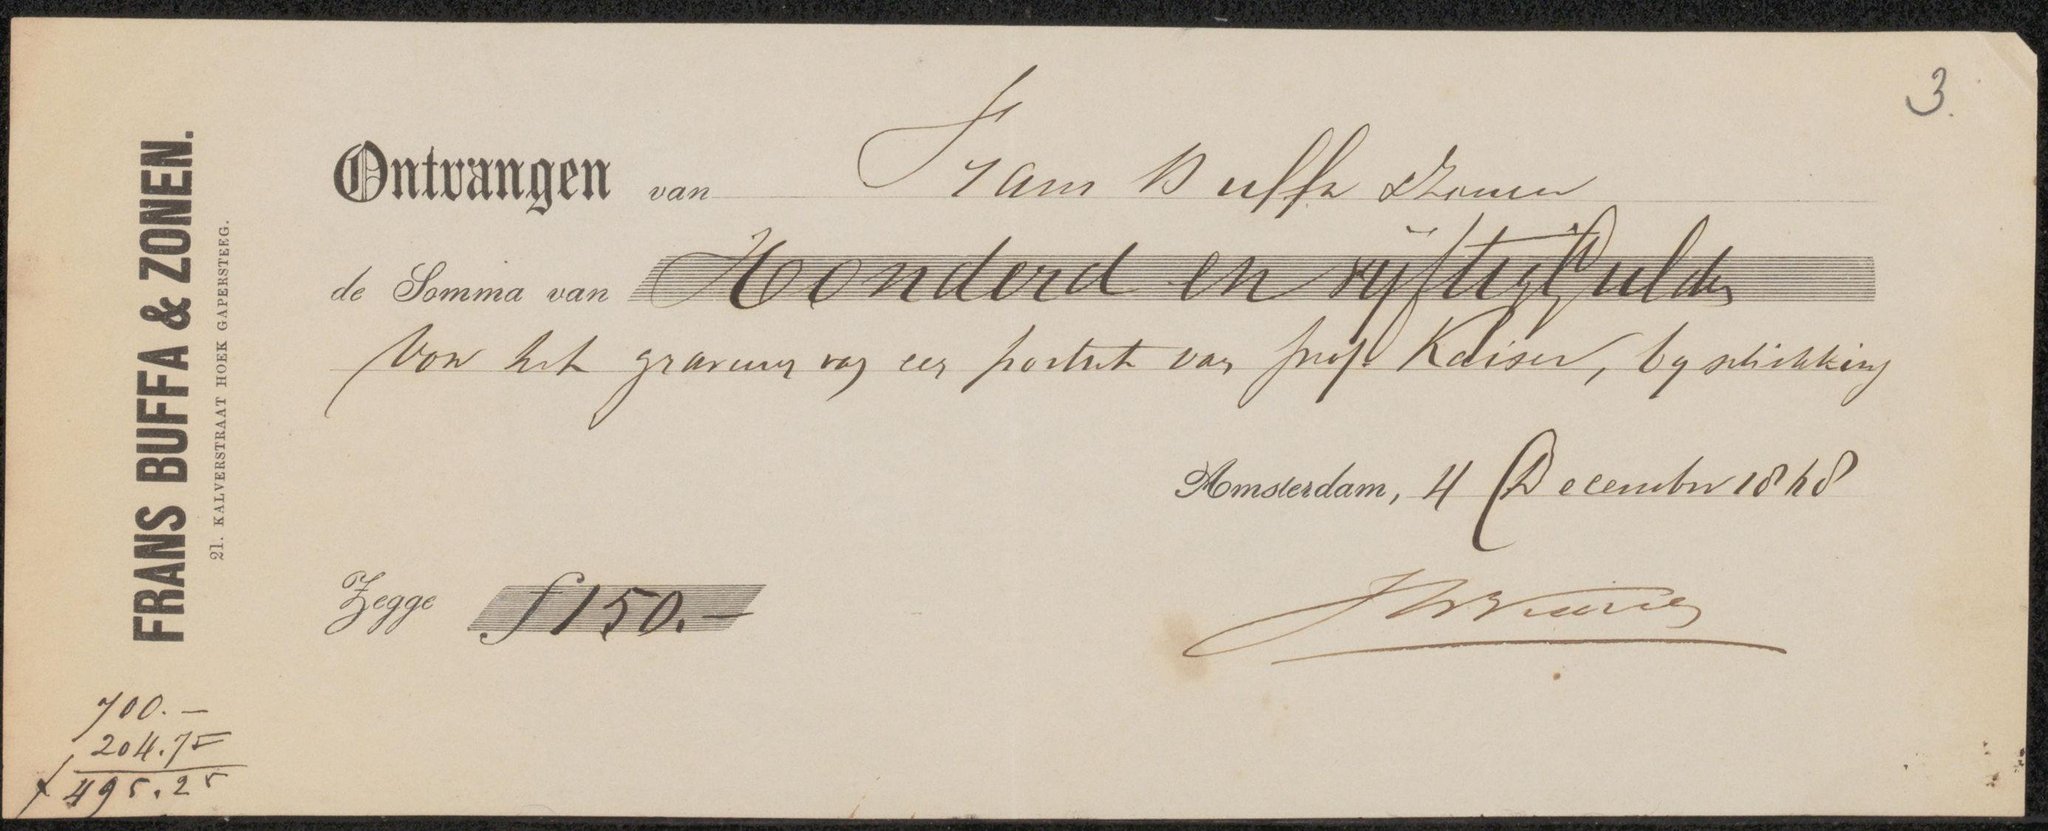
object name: ontvangstbewijs, kwitantie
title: Kwitantie voor Johann Wilhelm Kaiser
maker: johann wilhelm kaiser (i)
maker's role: draughtsman, print maker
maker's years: 1813-1900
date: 1848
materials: ink, paper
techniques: pen, printing, writing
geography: amsterdam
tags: the graphic arts, money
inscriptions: collector's mark: Lugt 2233